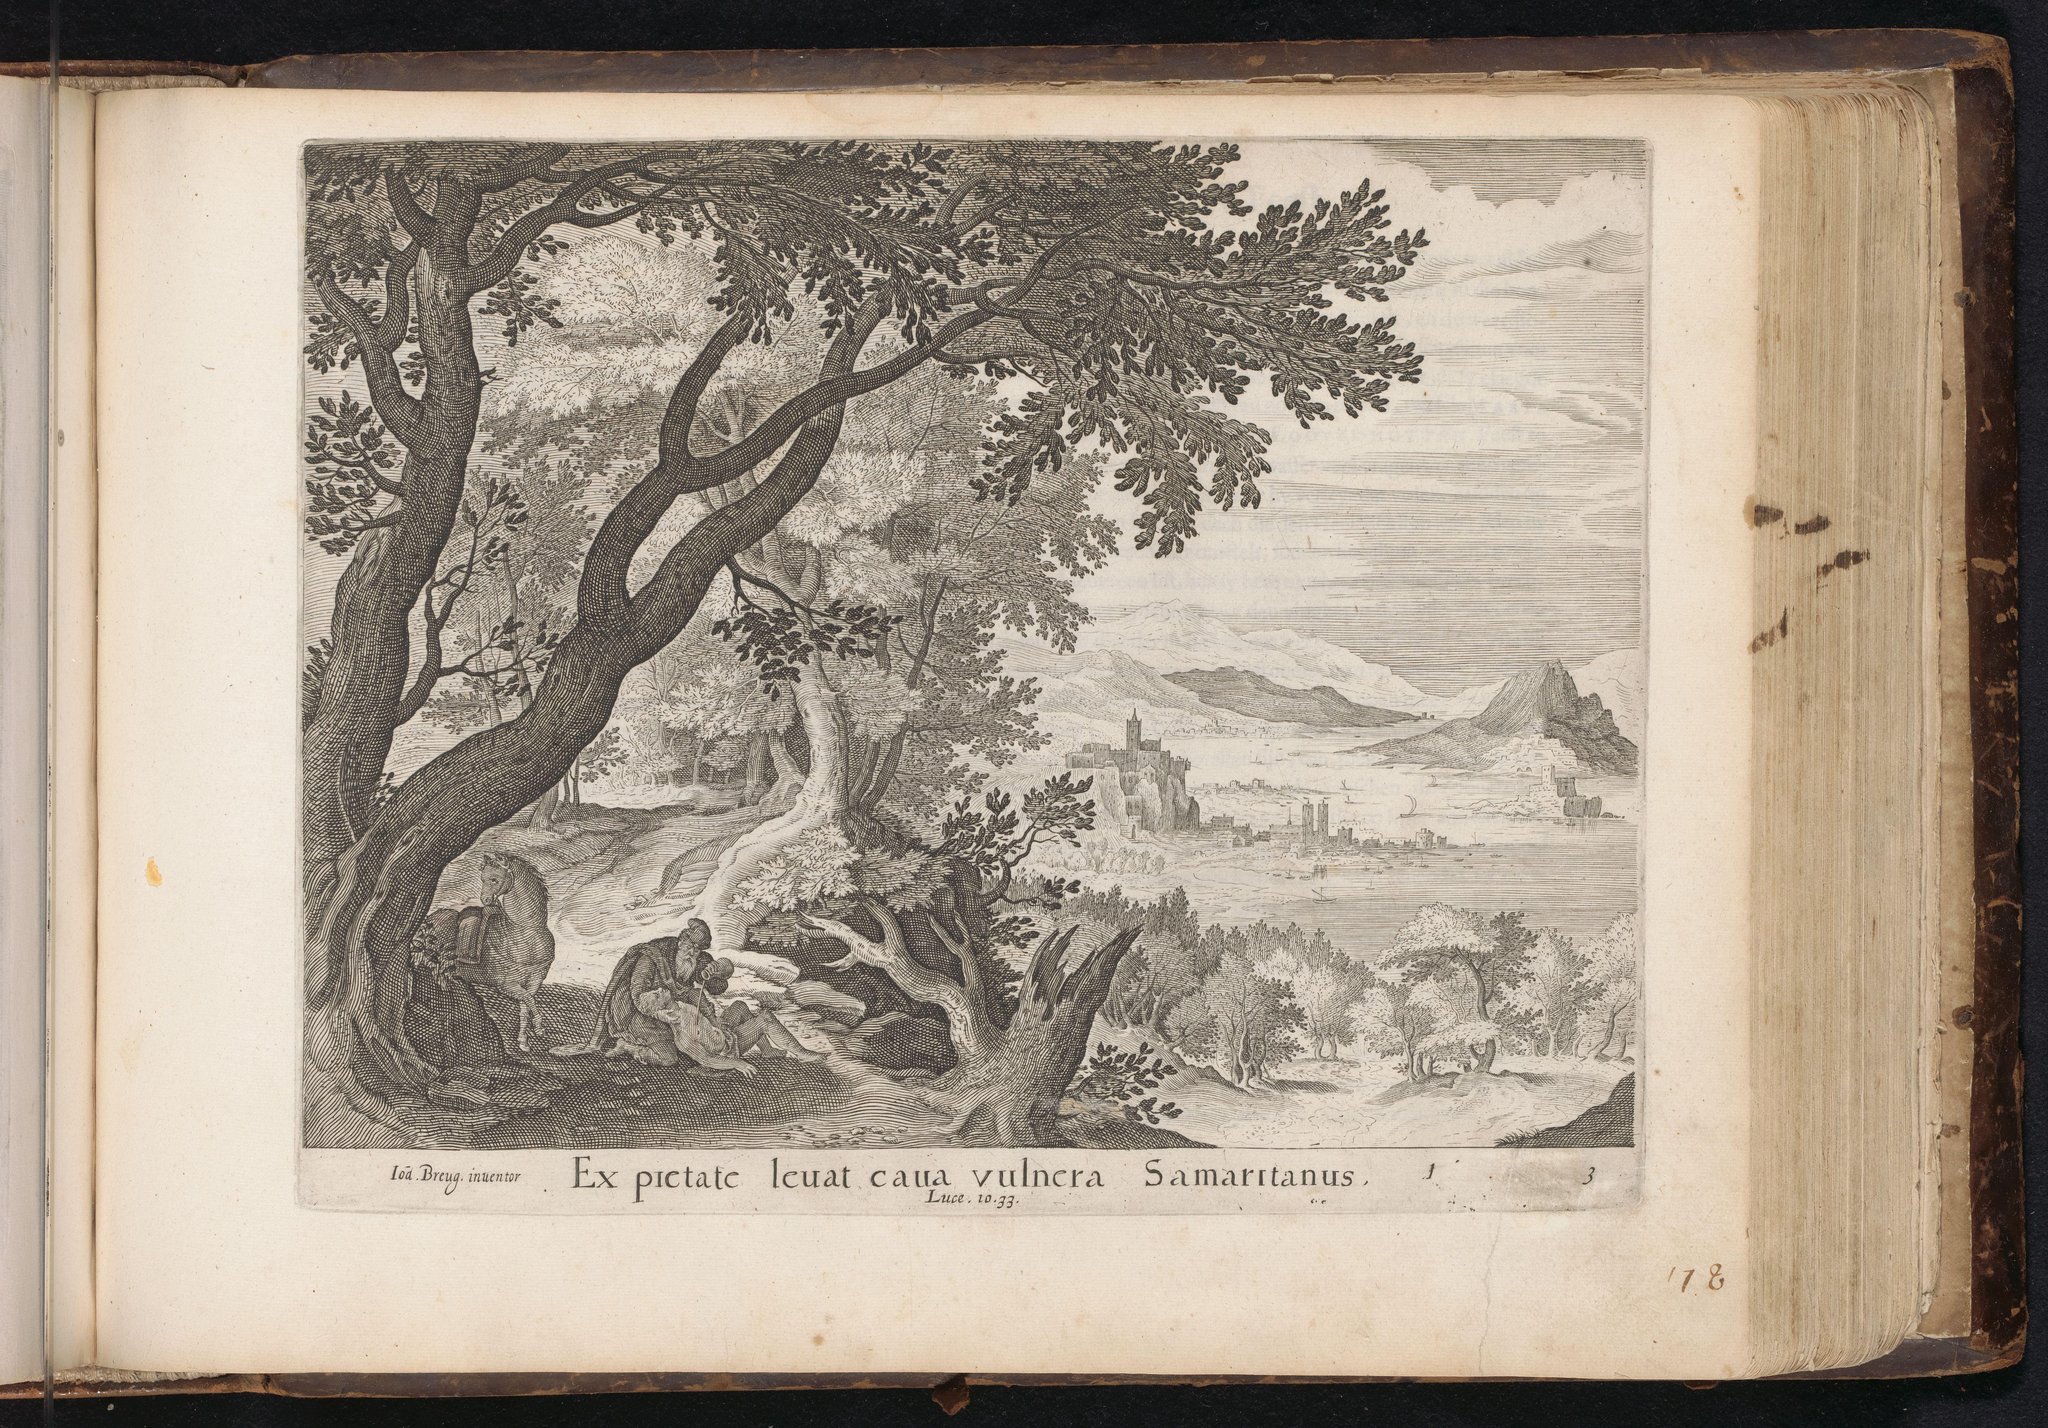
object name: print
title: Ex pietate leuat caua vulnera Samaritanus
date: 1646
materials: paper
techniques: engraving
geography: alkmaar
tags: forest, wood, a samaritan tending the wounds of the traveller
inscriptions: number: ‘78’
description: In een bosrijk rivierlandschap wordt de gewonde reiziger door de barmhartige Samaritaan verzorgd. Achter hem staat zijn paard. In de verte ligt een stad. Naar het Bijbelverhaal in Luc. 10: 25-37. Deze prent maakt deel uit van een album.